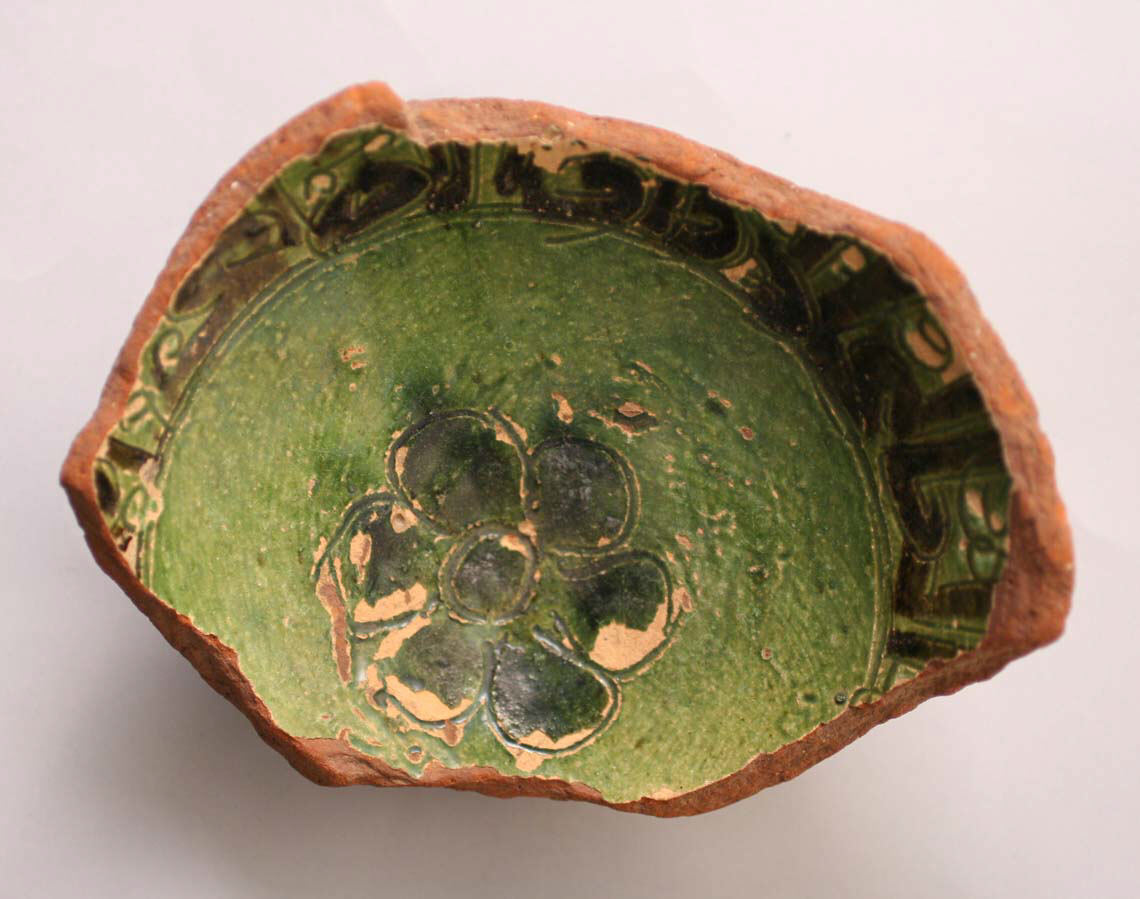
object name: ceramic fragment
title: Fragment of a Bowl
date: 1301-1500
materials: earthenware, glaze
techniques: coloring, incising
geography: egypt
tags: flowers